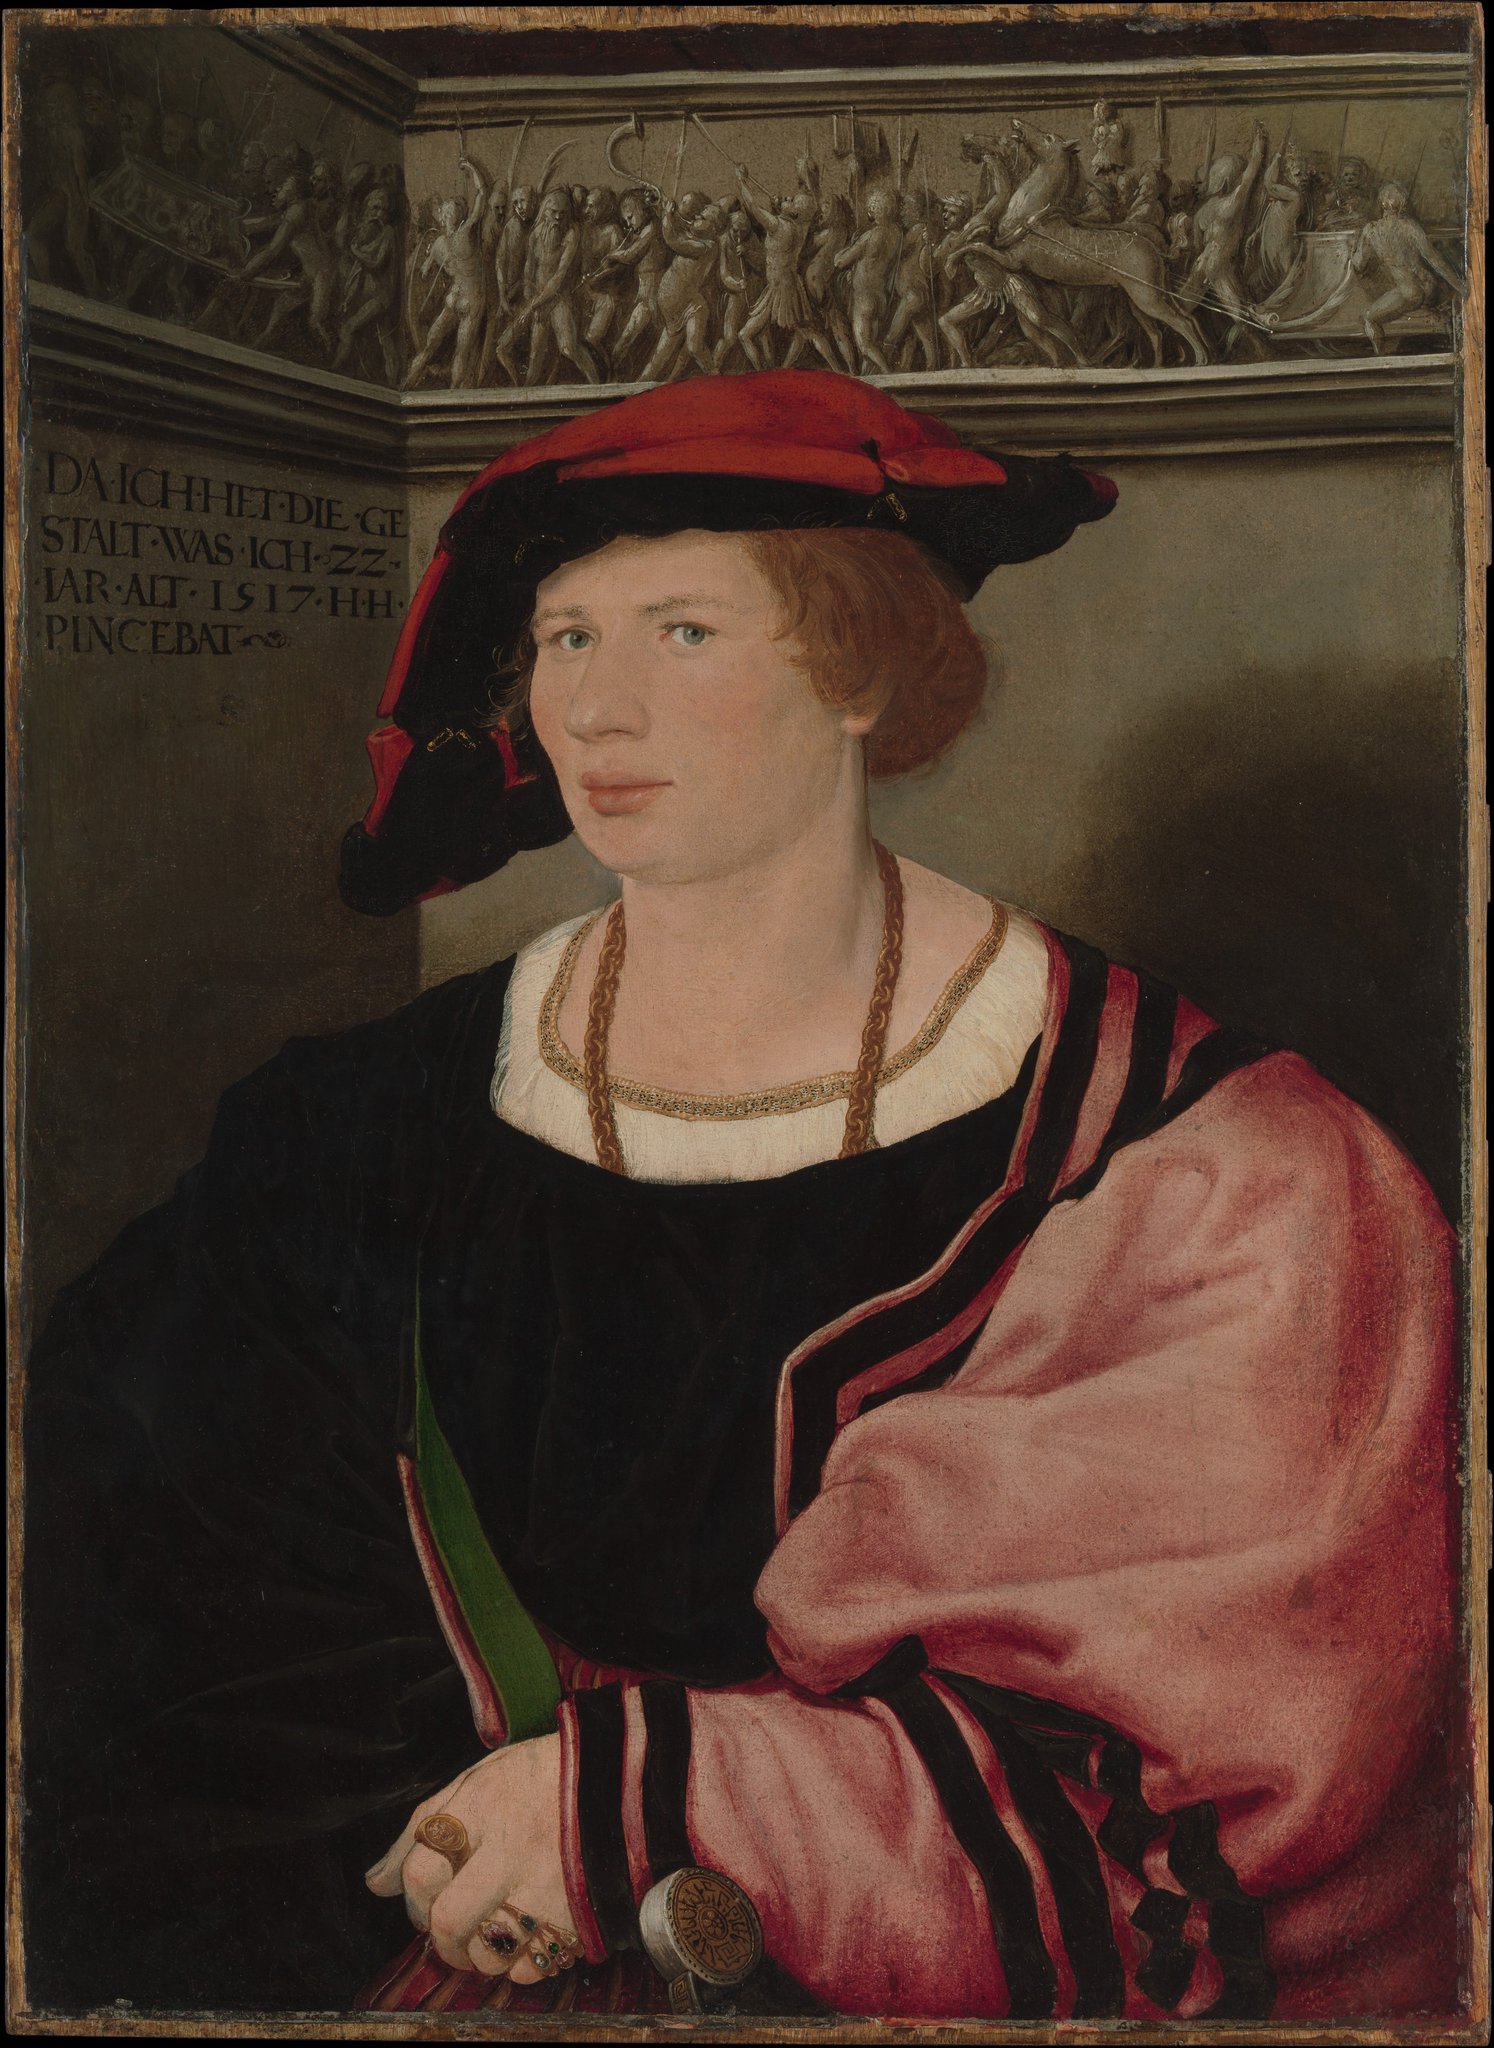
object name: painting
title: Benedikt von Hertenstein (born about 1495, died 1522)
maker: hans holbein the younger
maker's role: artist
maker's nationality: german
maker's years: 1497-1543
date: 1517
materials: gold, oil, paper, wood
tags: men,portraits